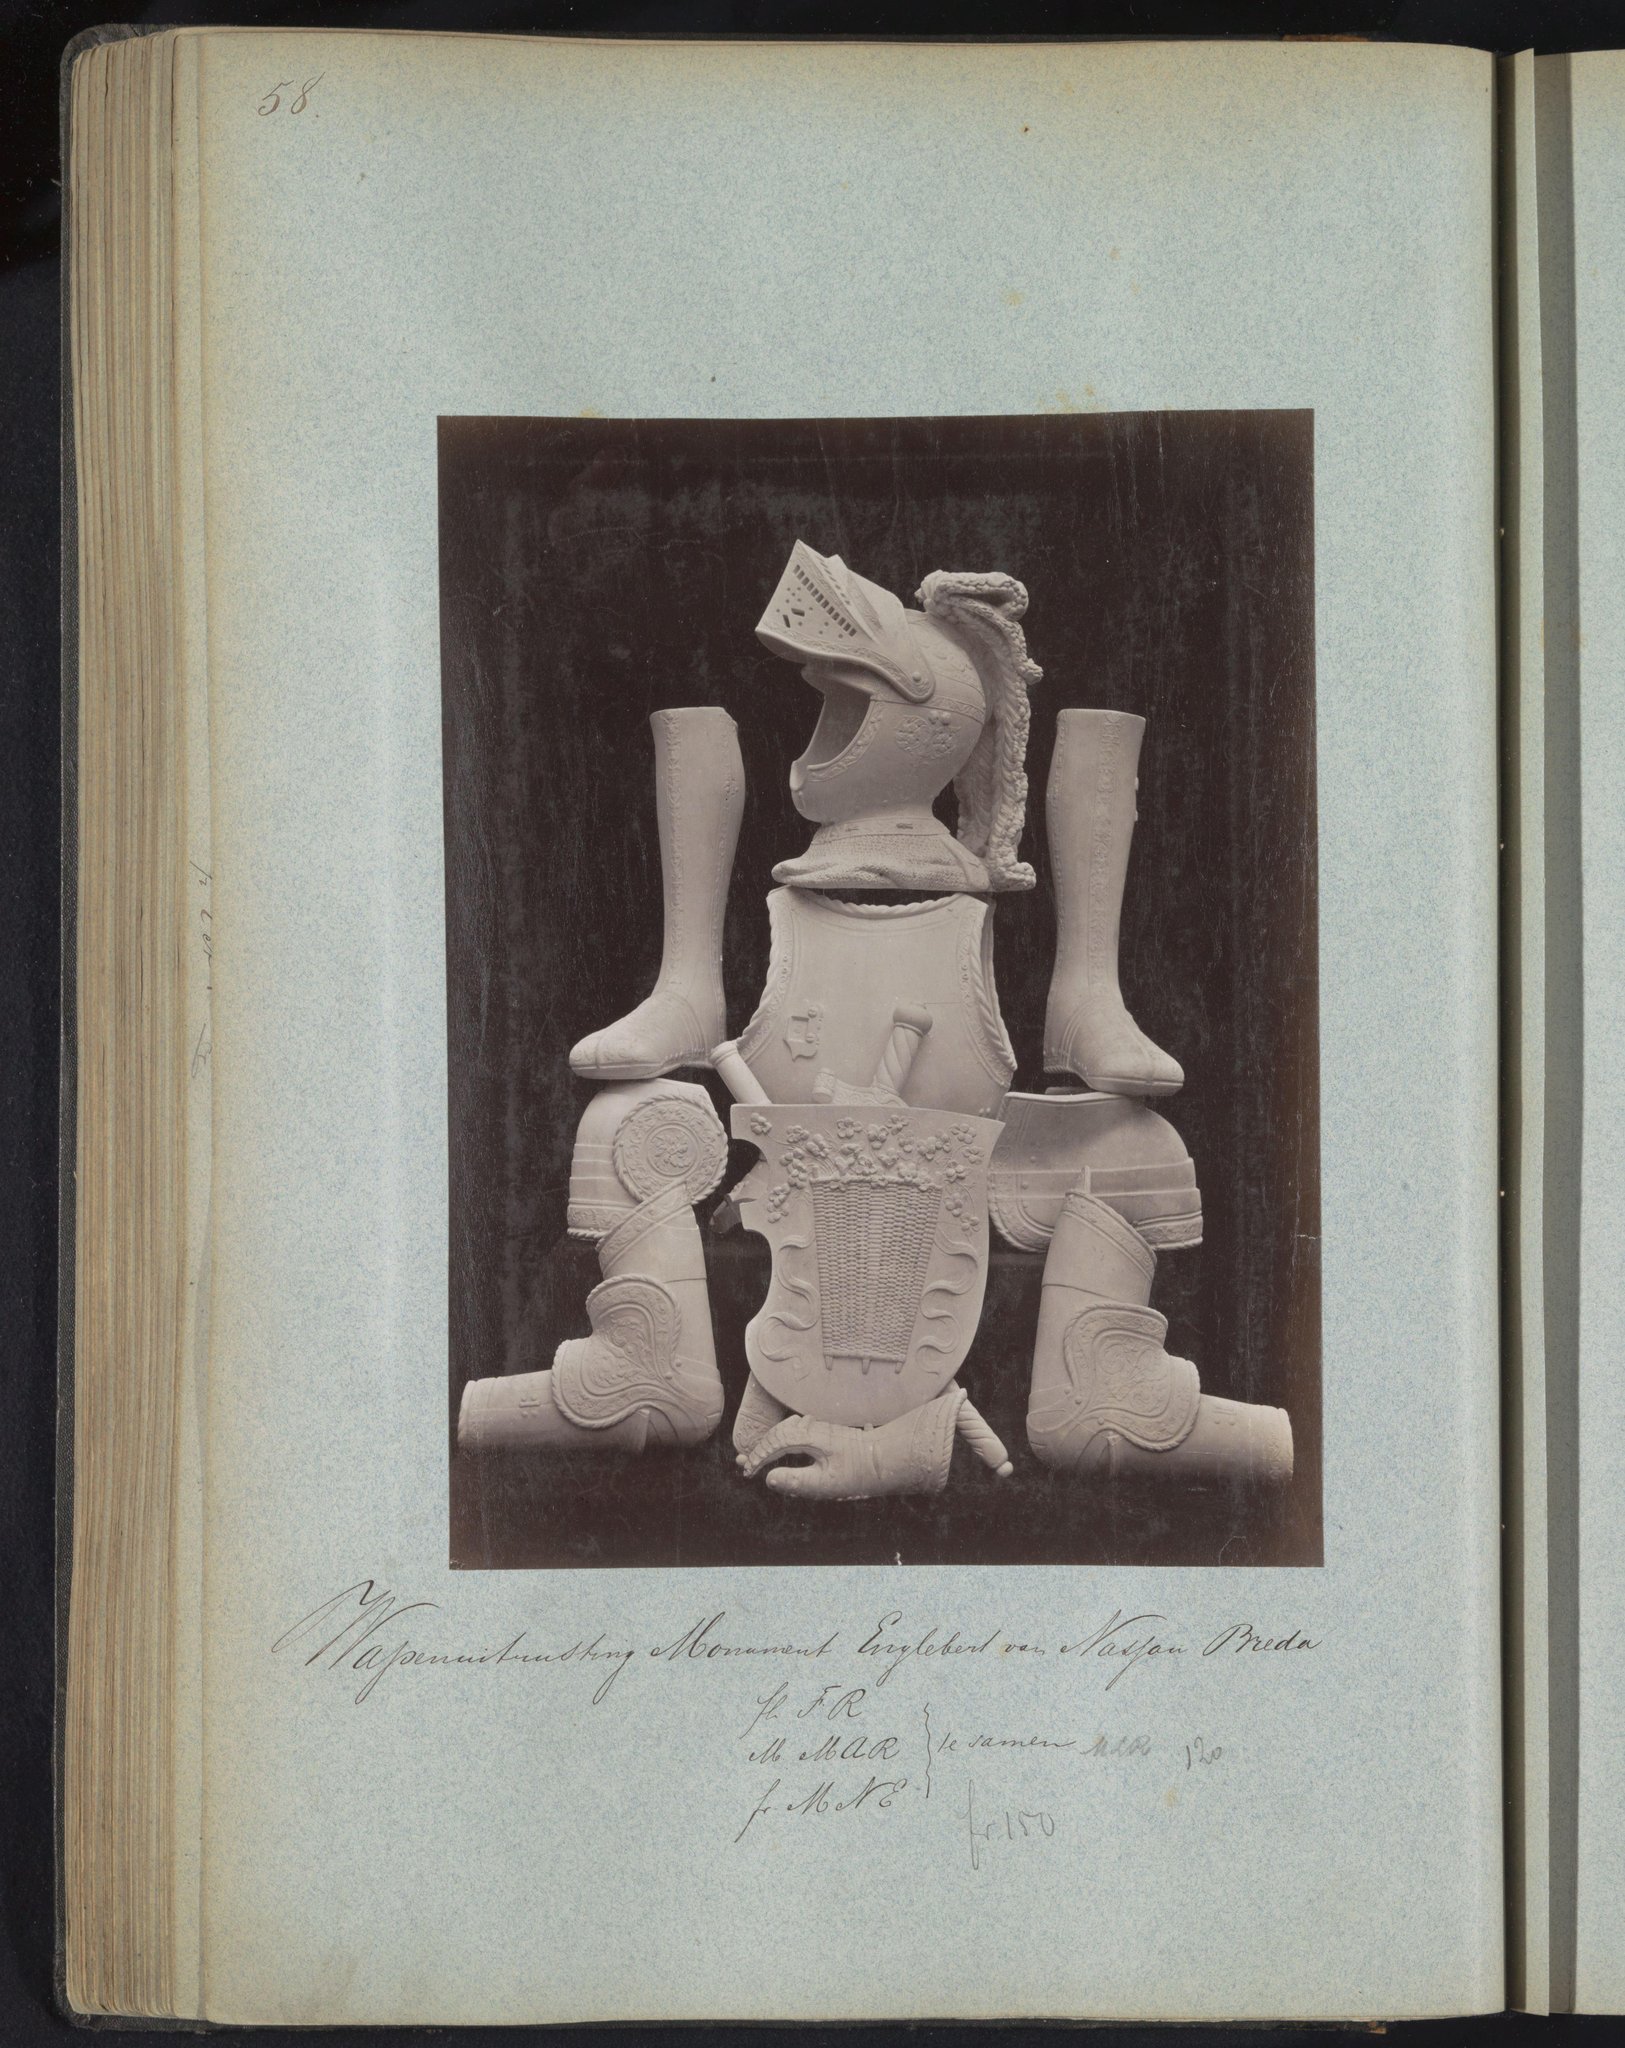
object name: photograph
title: Gipsen afgietsel van de wapenuitrusting van het grafmonument van Engelbrecht II, graaf van Nassau, uit de Prinsenkapel van de Onze-Lieve-Vrouwekerk te Breda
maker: Anonymous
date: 1875-1900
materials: paper, photographic support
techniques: albumen print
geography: breda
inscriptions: annotation, annotation: ‘Wapenuitrusting Monument Englebert van Nassau Breda’